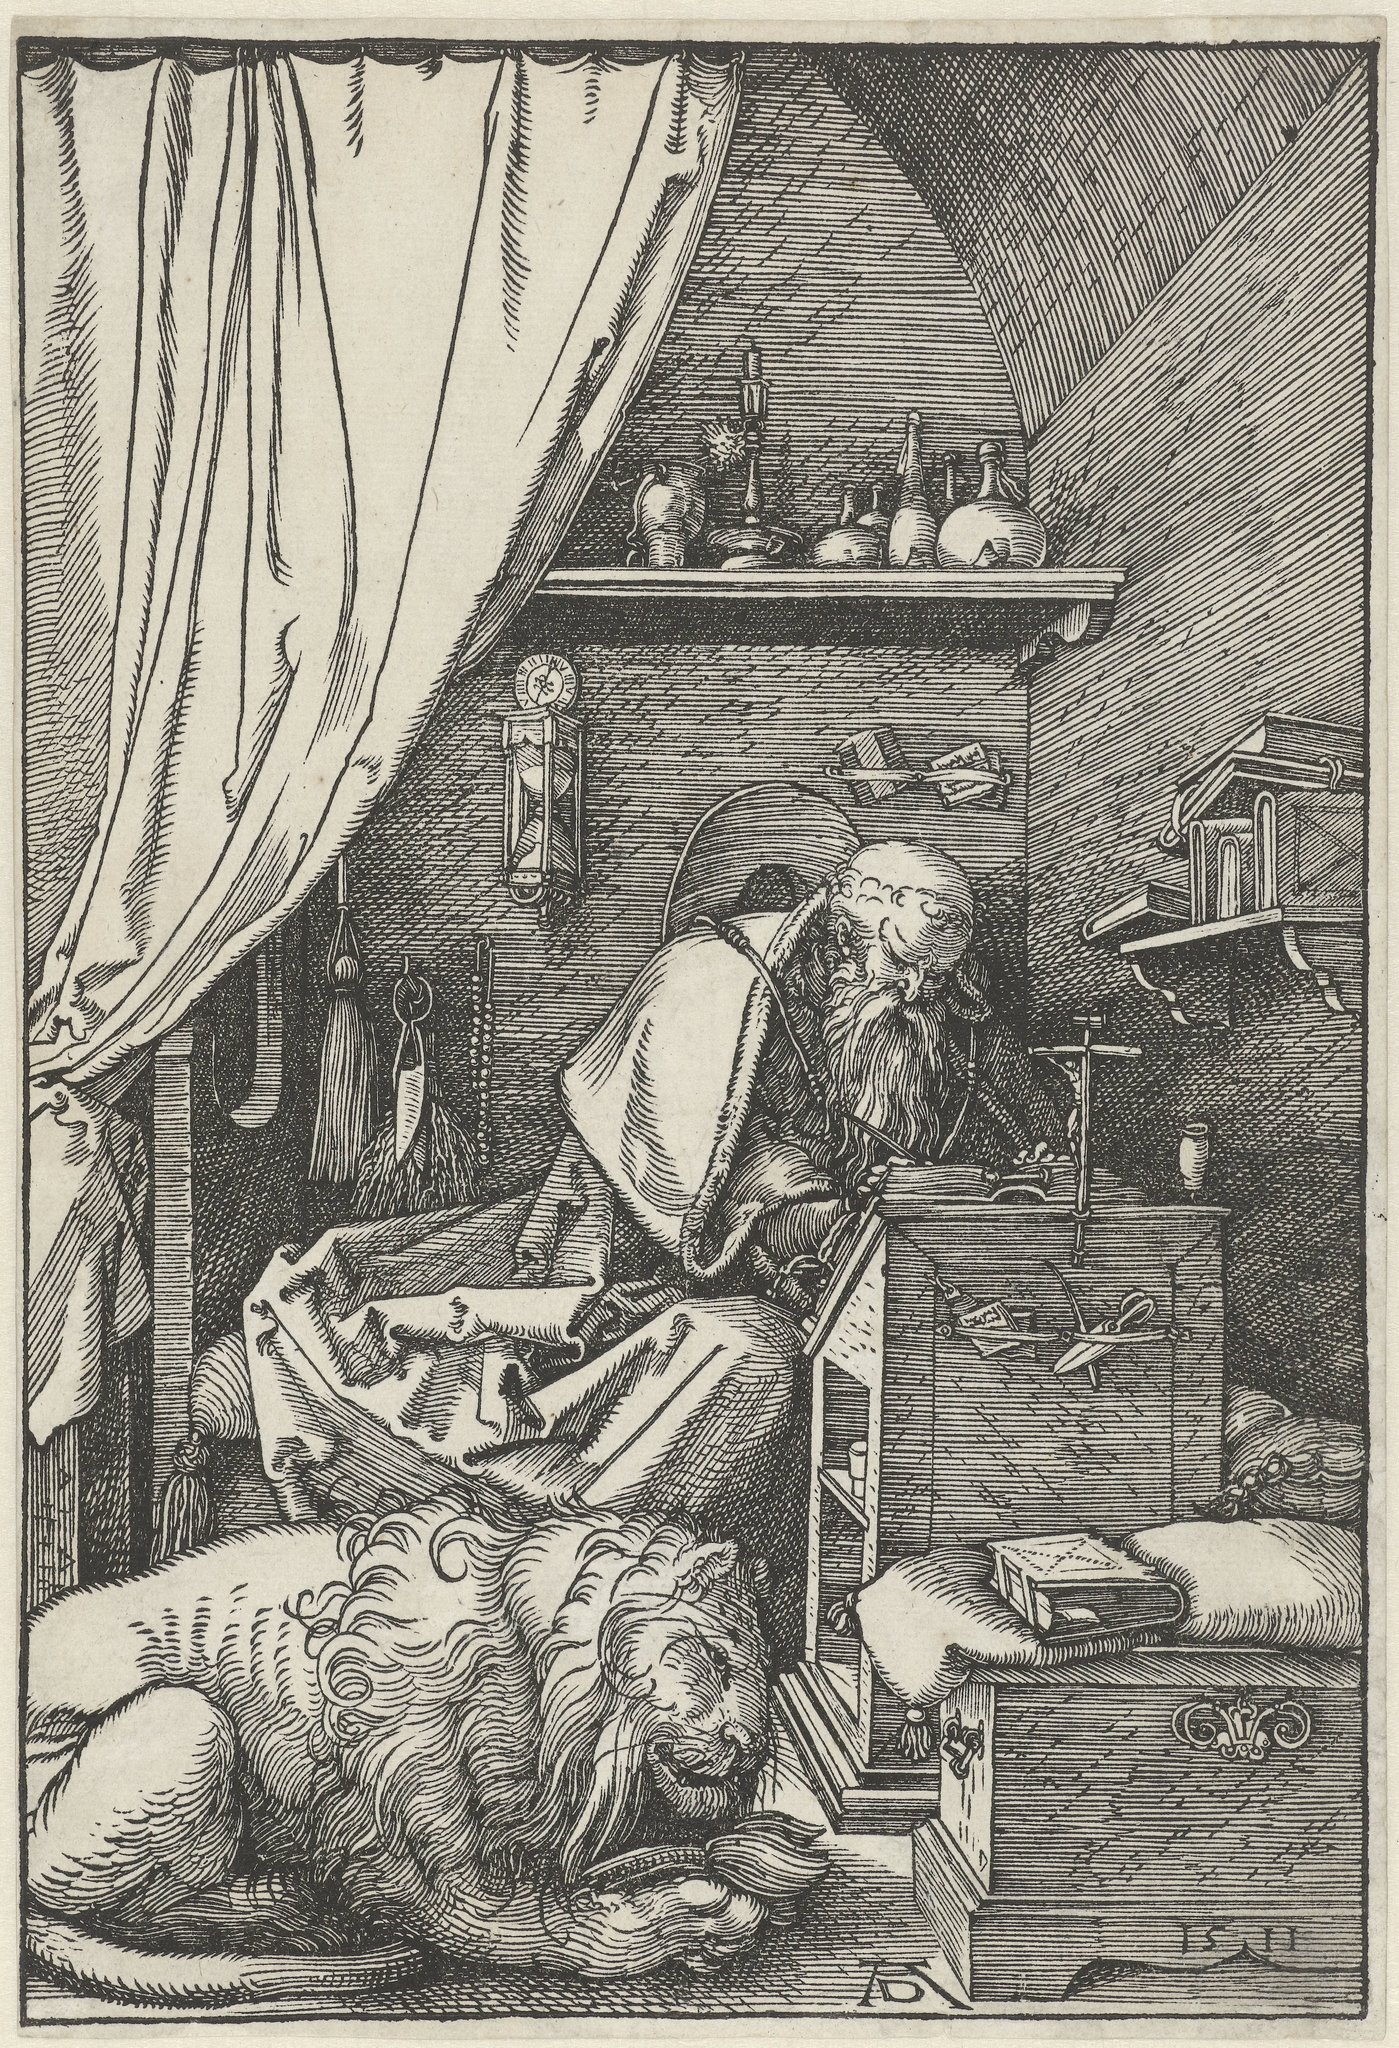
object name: print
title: De Heilige Hiëronymus in zijn studeervertrek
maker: albrecht dürer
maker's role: draughtsman, painter, print maker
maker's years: 1471-1528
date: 1511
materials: paper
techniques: woodcut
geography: nuremberg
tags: st. jerome as doctor of the latin church in his study with book, pen and ink; lion and cardinal's hat beside him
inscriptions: collector's mark: Lugt 2228, collector's mark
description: De Heilige Hiëronymus zit in een studeervertrek te schrijven aan een lezenaar bij een gordijn. Op de voorgrond ligt een leeuw.